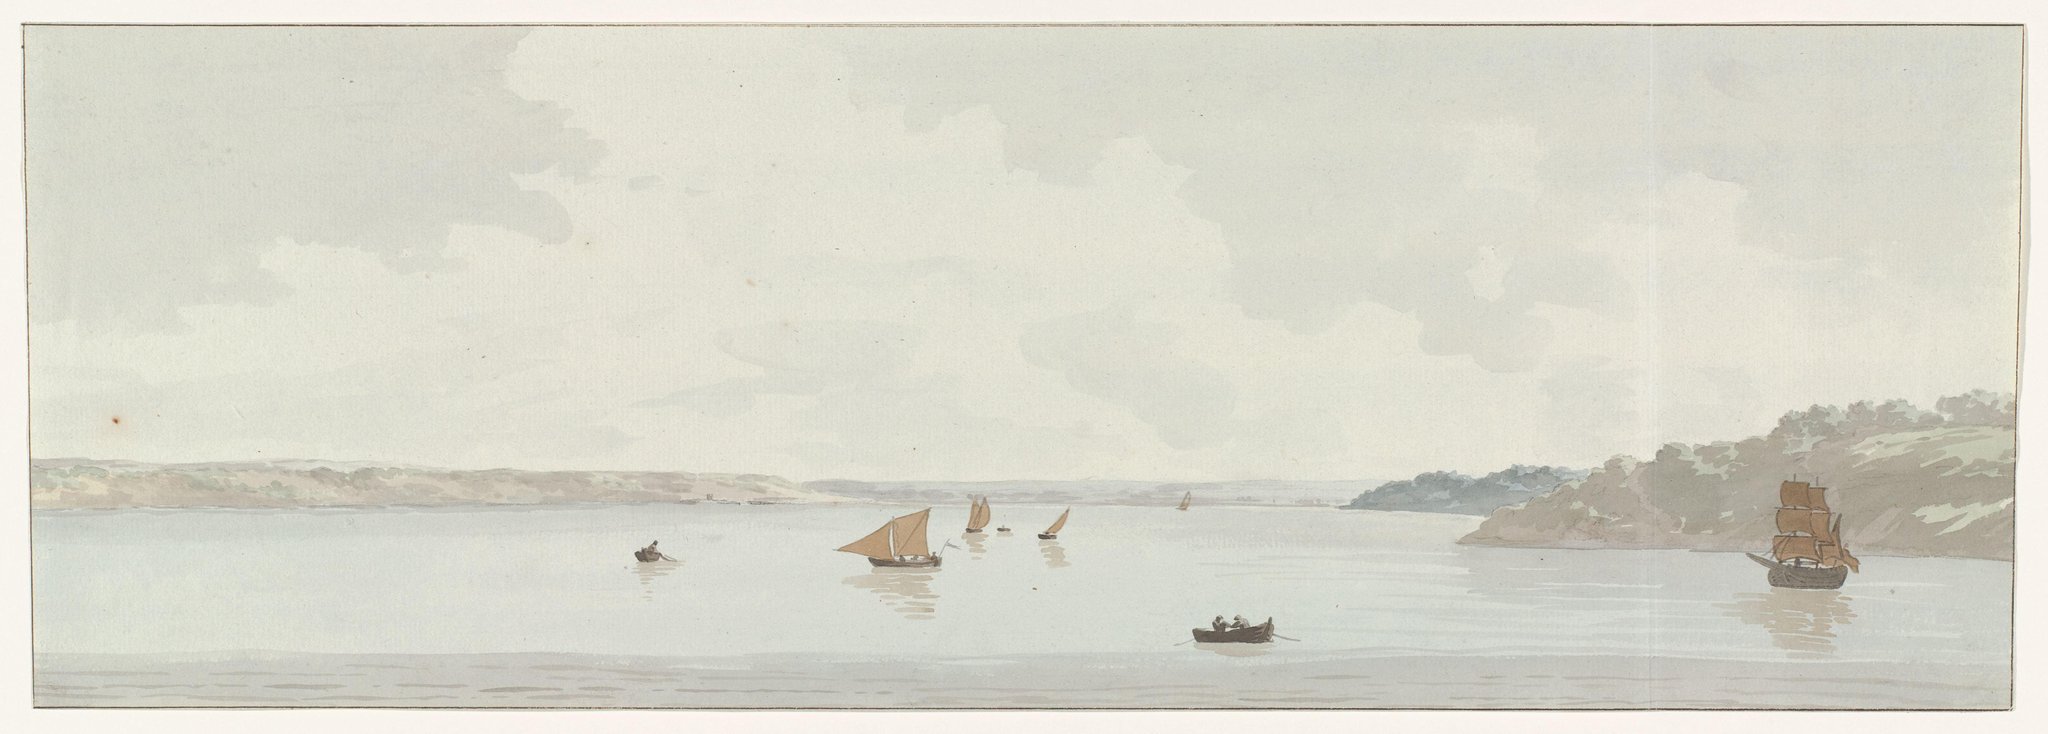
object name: drawing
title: Gezicht op een deel van het Mare Piccolo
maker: louis ducros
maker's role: draughtsman, print maker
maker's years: 1748-1810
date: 1778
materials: chalk, paper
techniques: brush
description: Tekening uit het album 'Voyage en Italie, en Sicile et à Malte', 1778.